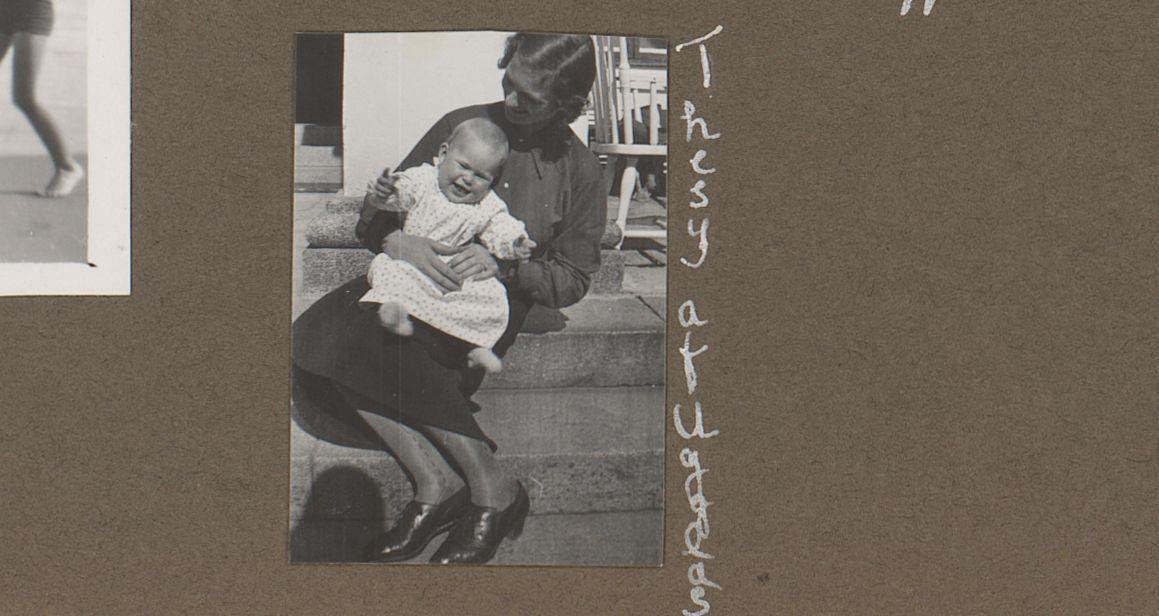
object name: album leaf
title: Vrouw met Thesy af Ugglas als baby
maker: Anonymous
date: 1933-1934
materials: paper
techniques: gelatin silver print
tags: mother and baby or young child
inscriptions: inscription: ‘Thesy af Ugglas’